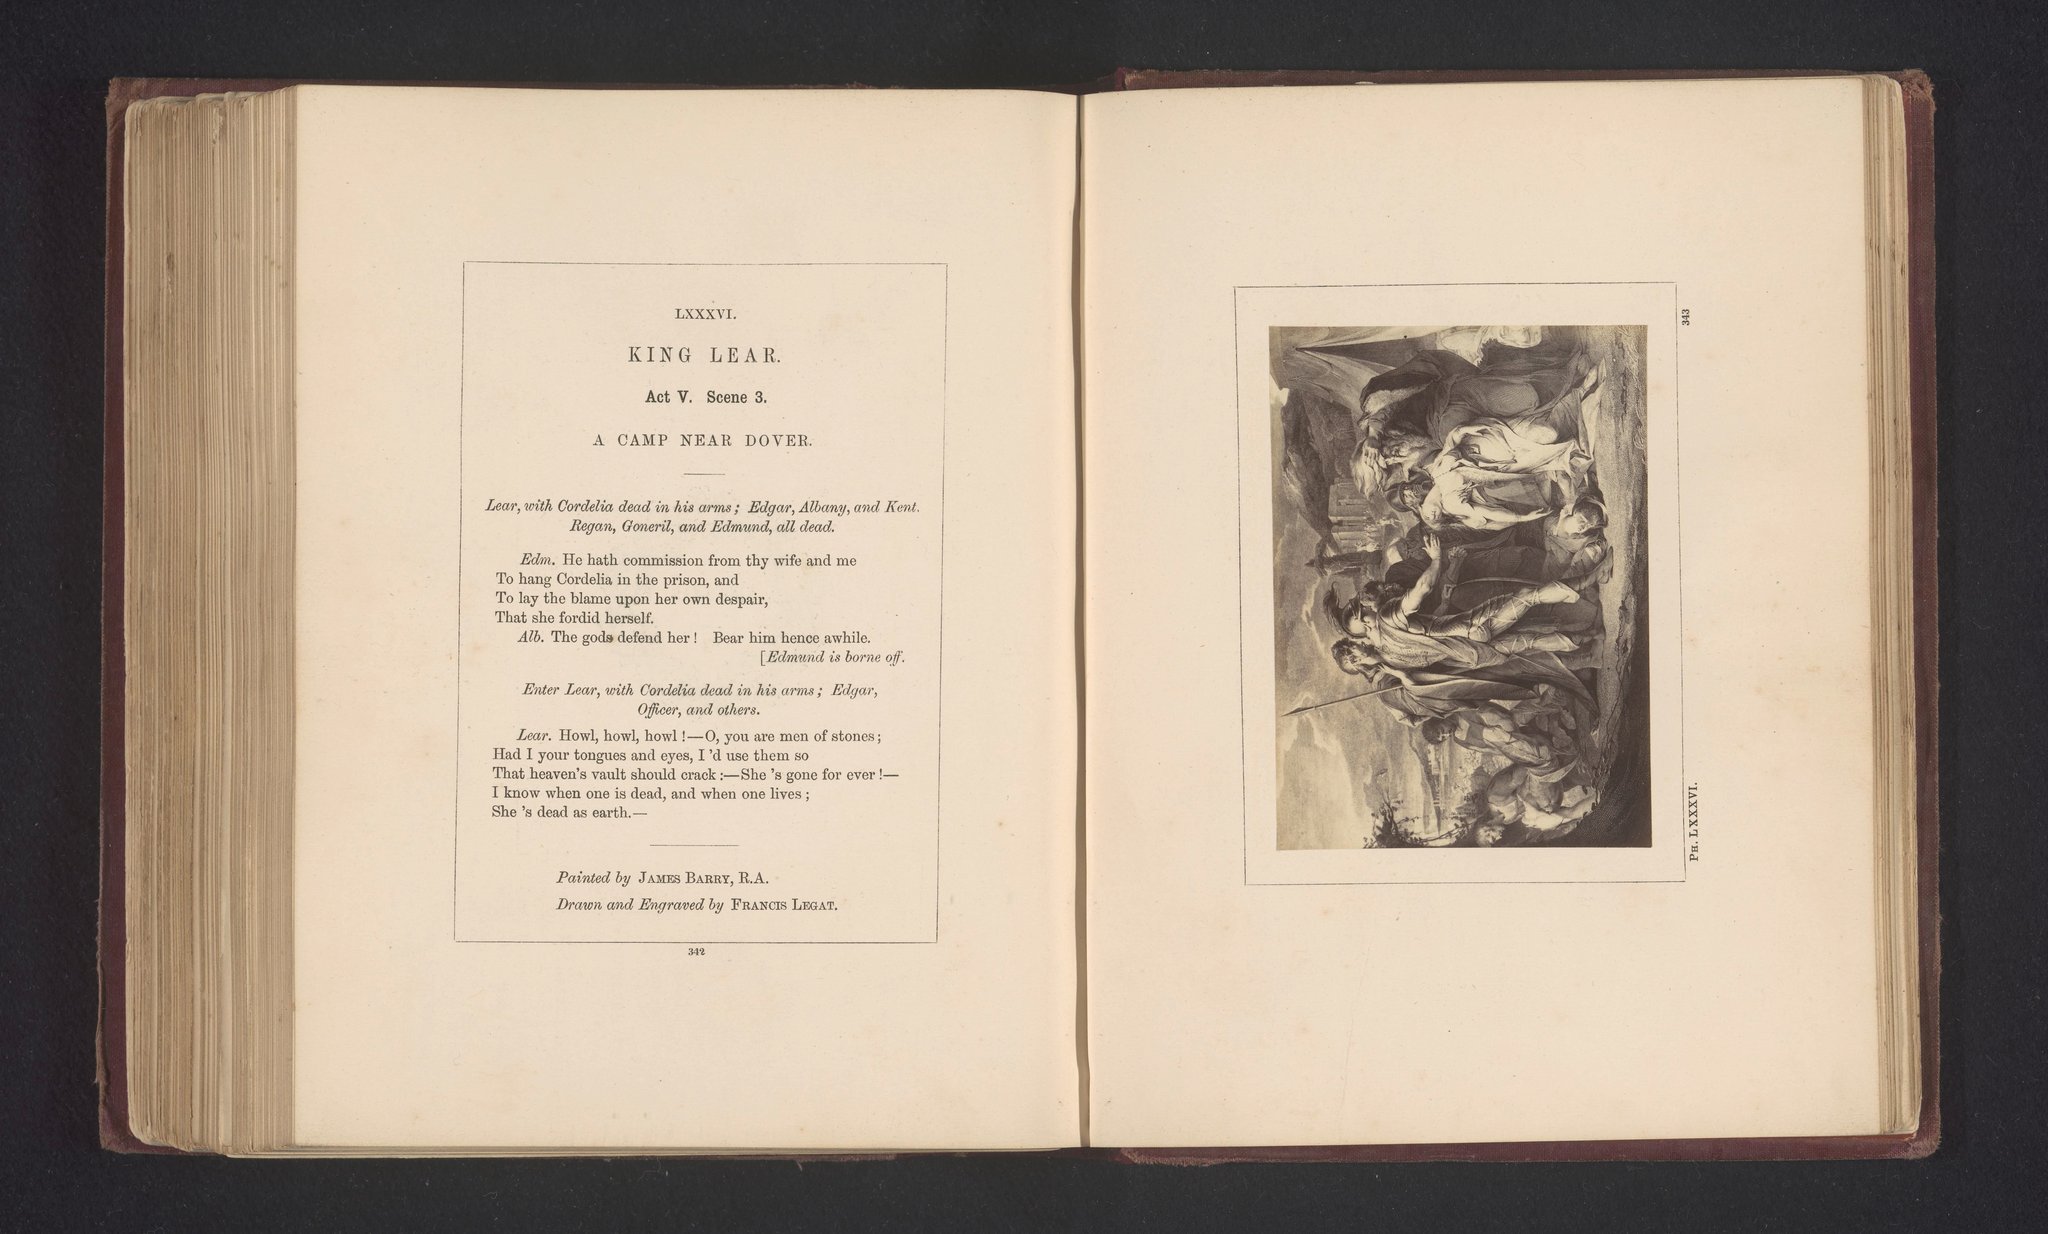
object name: page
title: Fotoreproductie van een prent naar een schilderij door James Barry, voorstellend een scene uit Koning Lear door William Shakespeare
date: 1854-1867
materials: photographic support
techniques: albumen print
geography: london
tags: king lear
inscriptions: number: ‘Ph. LXXXVI. 343’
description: Te zien is akte V, scene 3 met koning Lear met het dode lichaam van Cordelia in zijn handen.